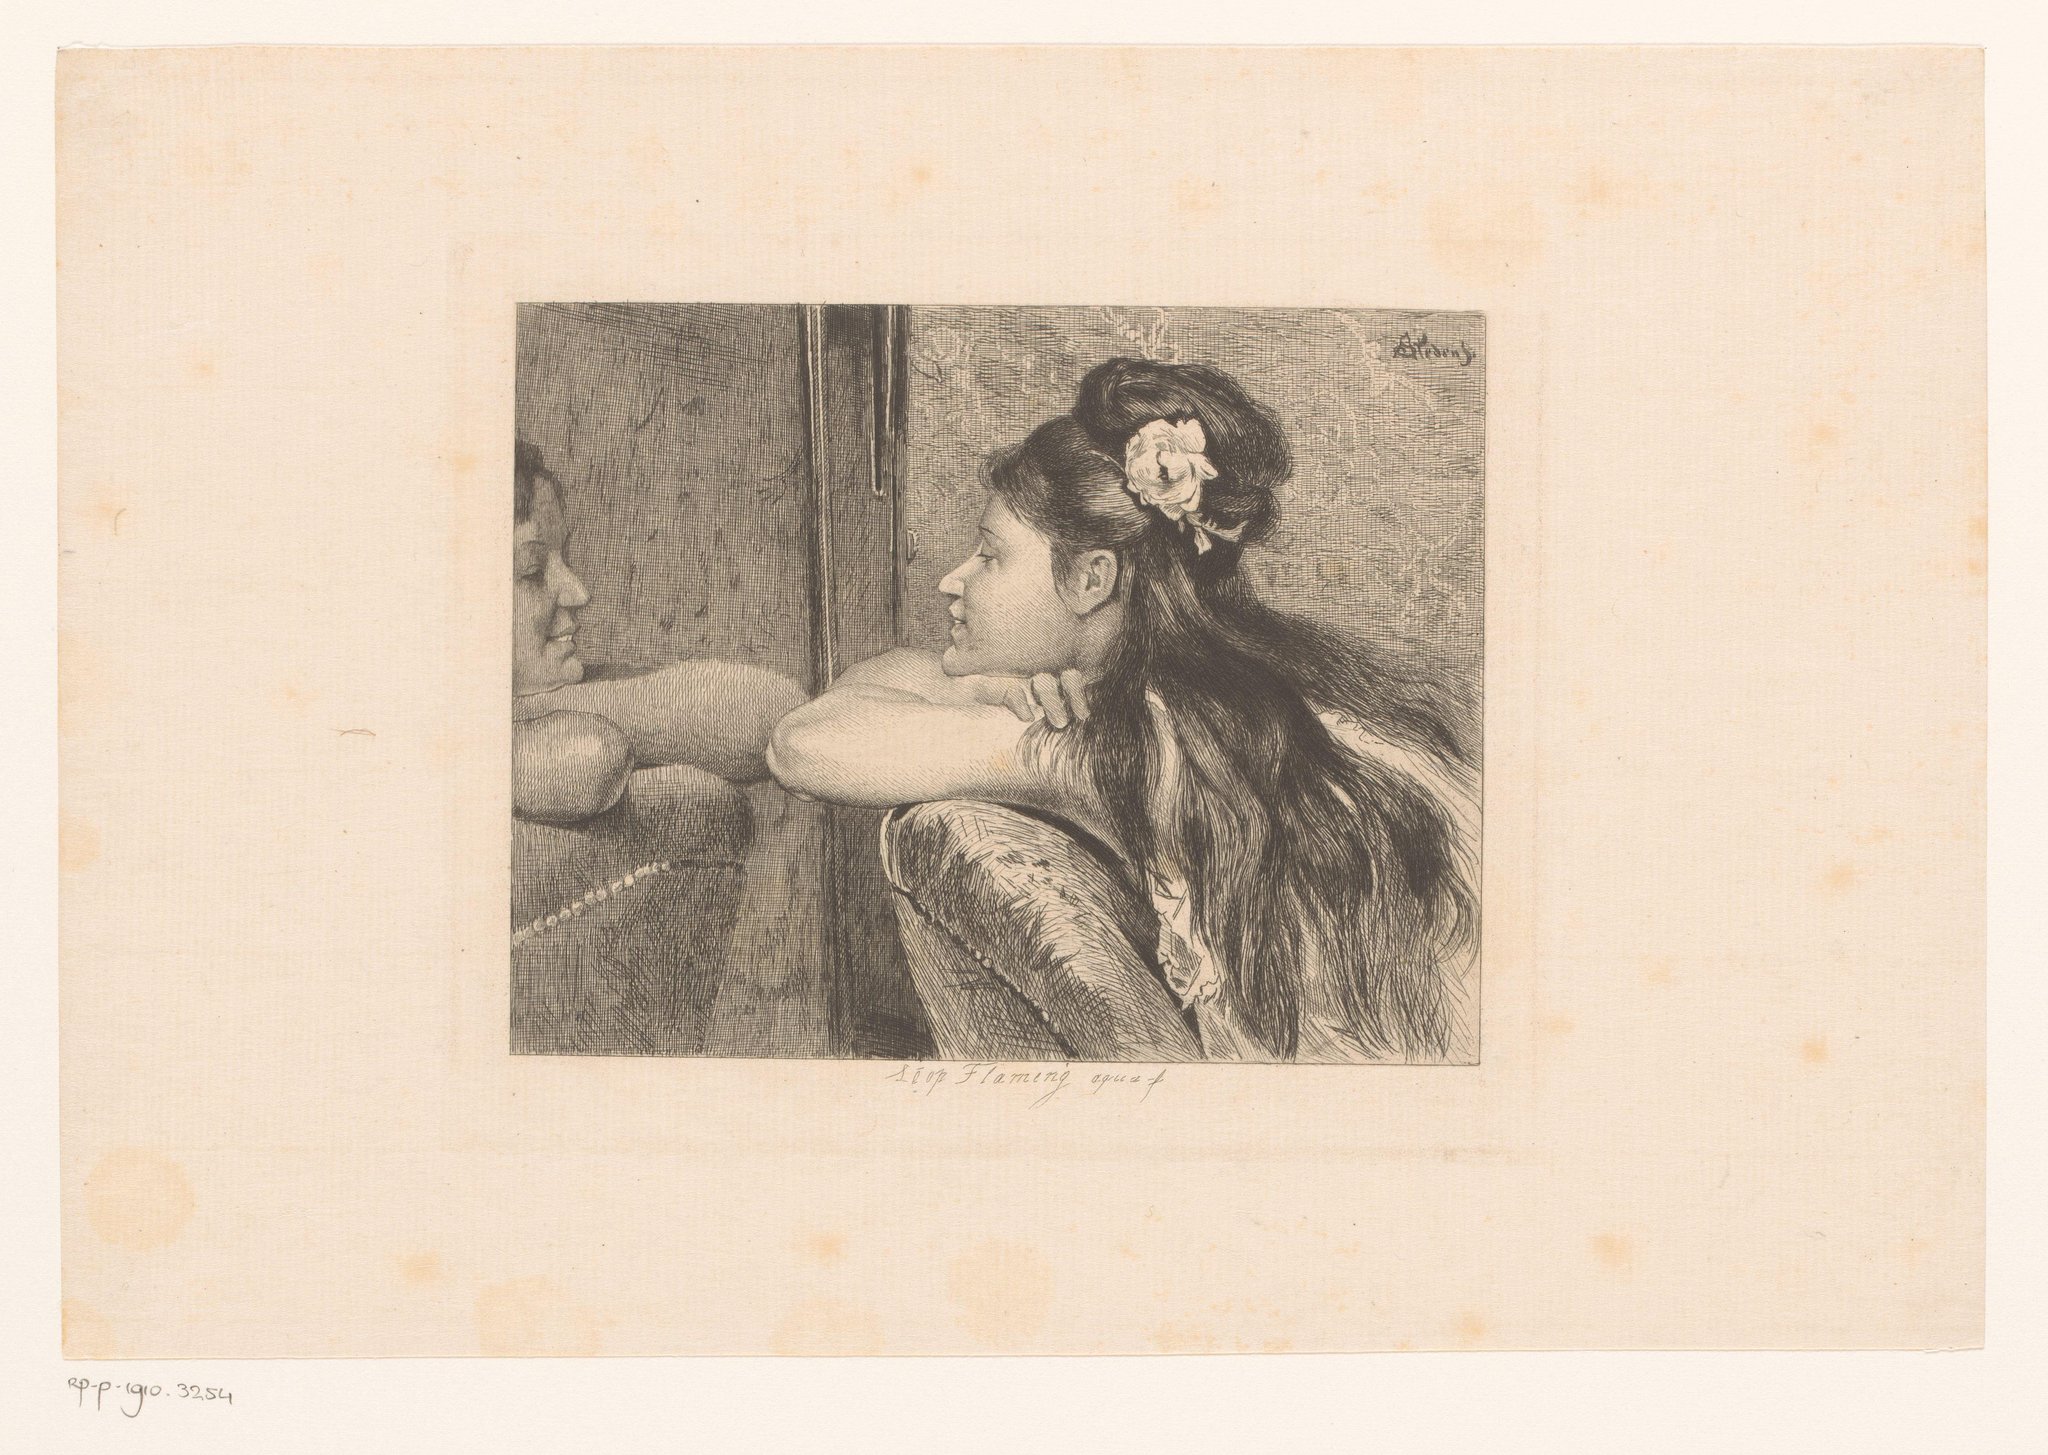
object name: print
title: La coquette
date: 1878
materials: paper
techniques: etching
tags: adolescent, young woman, maiden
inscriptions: collector's mark: Lugt 2228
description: Prent uit: Gazette des beaux-arts (april 1878), p. 338-339.